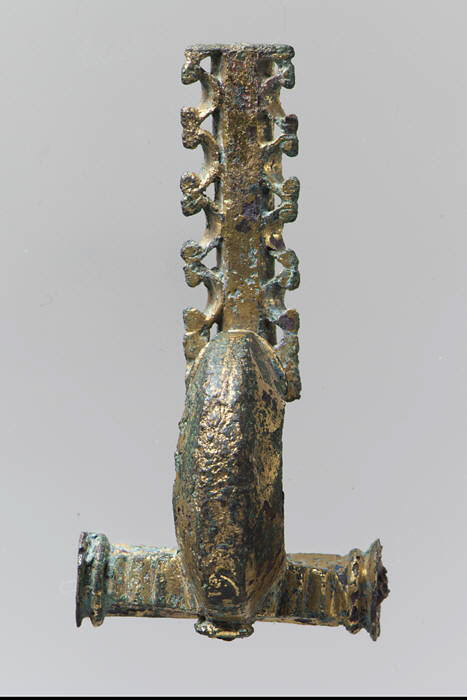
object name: brooch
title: Crossbow Brooch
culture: roman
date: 301-400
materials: bronze, gilt